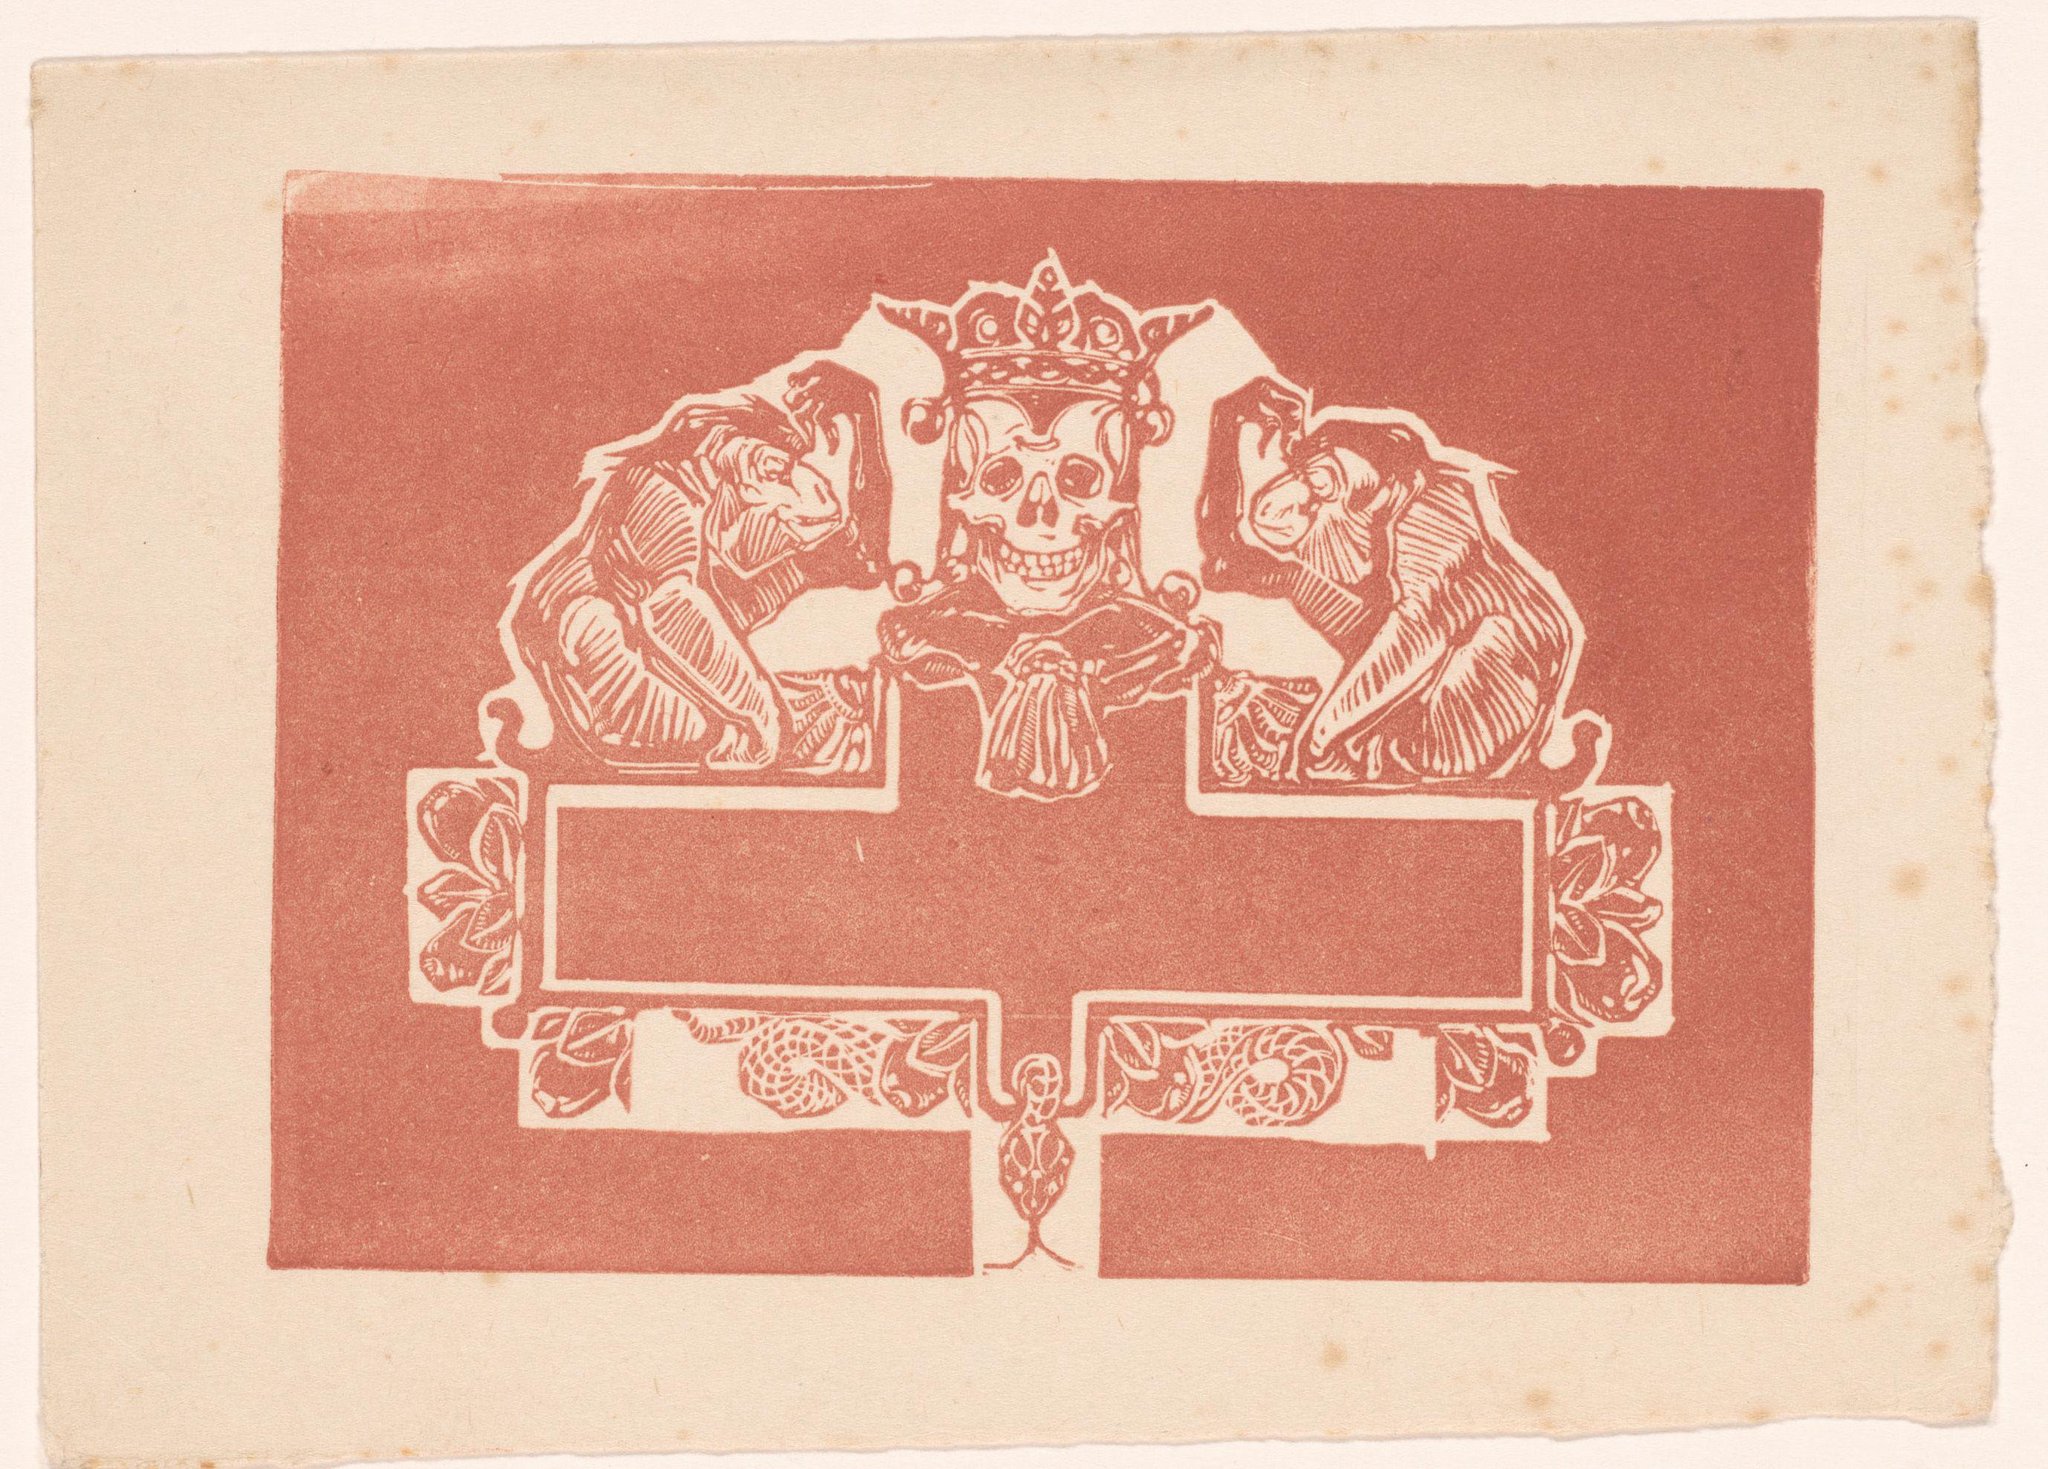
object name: print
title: Titelvignet met gekroond schedel en apen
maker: bernard willem wierink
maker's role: draughtsman, print maker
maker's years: 1856-1939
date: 1910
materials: paper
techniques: relief print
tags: (human) skull, monkeys, apes, fable of reynard the fox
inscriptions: collector's mark: Lugt 2228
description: Ontwerp voor: Streuvels, Stijn (Frank Lateur). Reinaert de Vos naar verschillende uitgaven van het middeleeuwsche epos. Amsterdam: L.J. Veen, 1910. Deze prent is vermoedelijk een plaatsnede, ook al wordt in de literatuur veelal gesproken over een houtsnede. Voor zover Wierink zijn prenten in hoogdruk zelf nader heeft omschreven, heeft hij altijd de term 'plaatsnede' gebruikt.